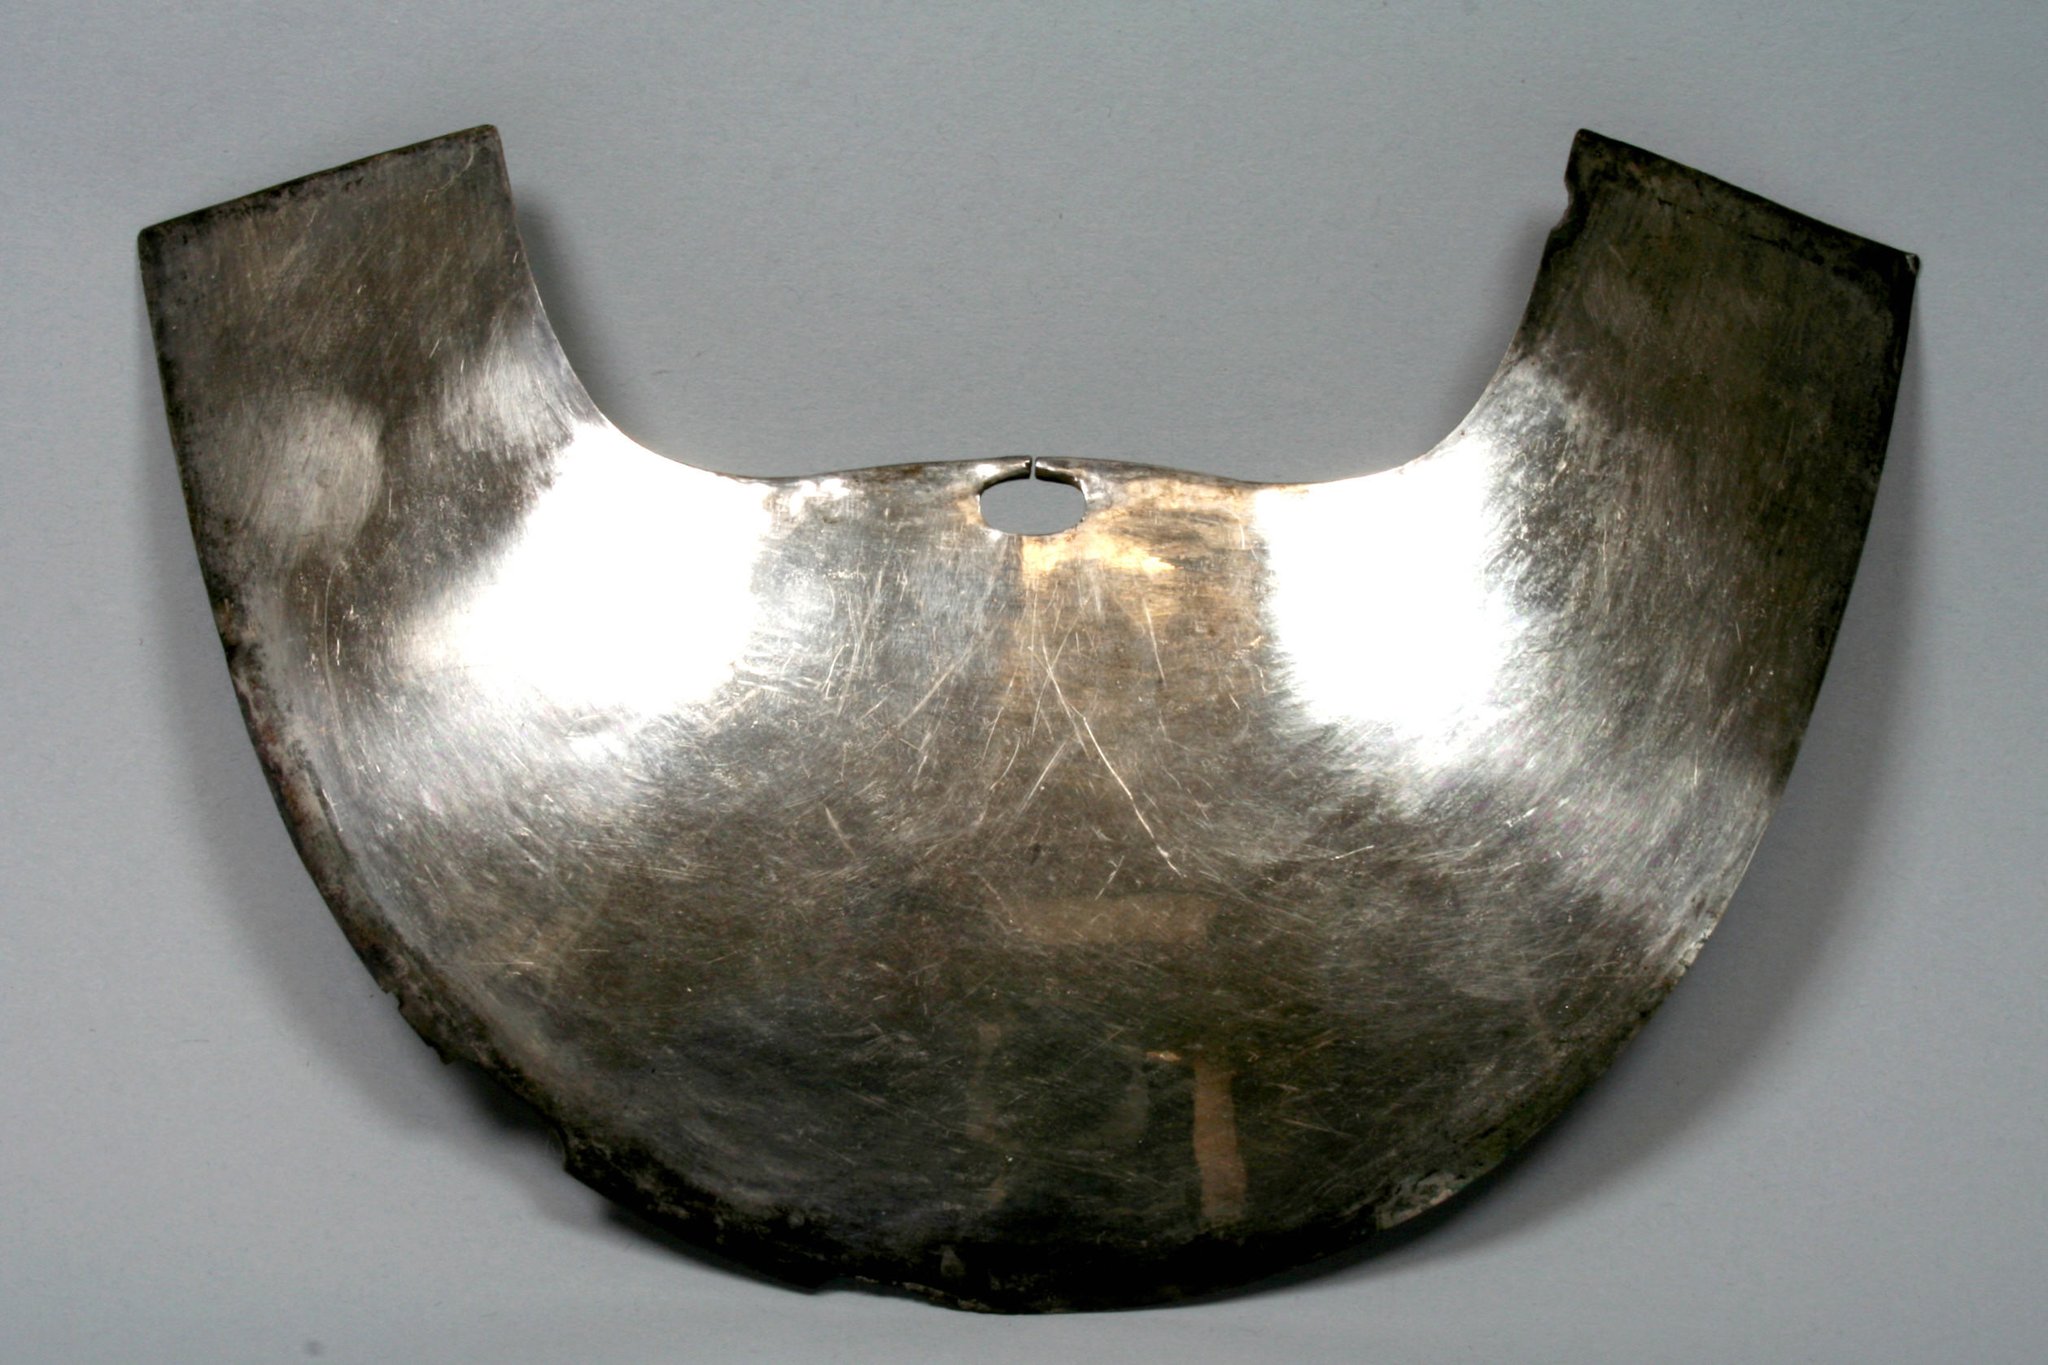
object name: nose ornament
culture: moche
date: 501-700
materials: silver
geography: peru